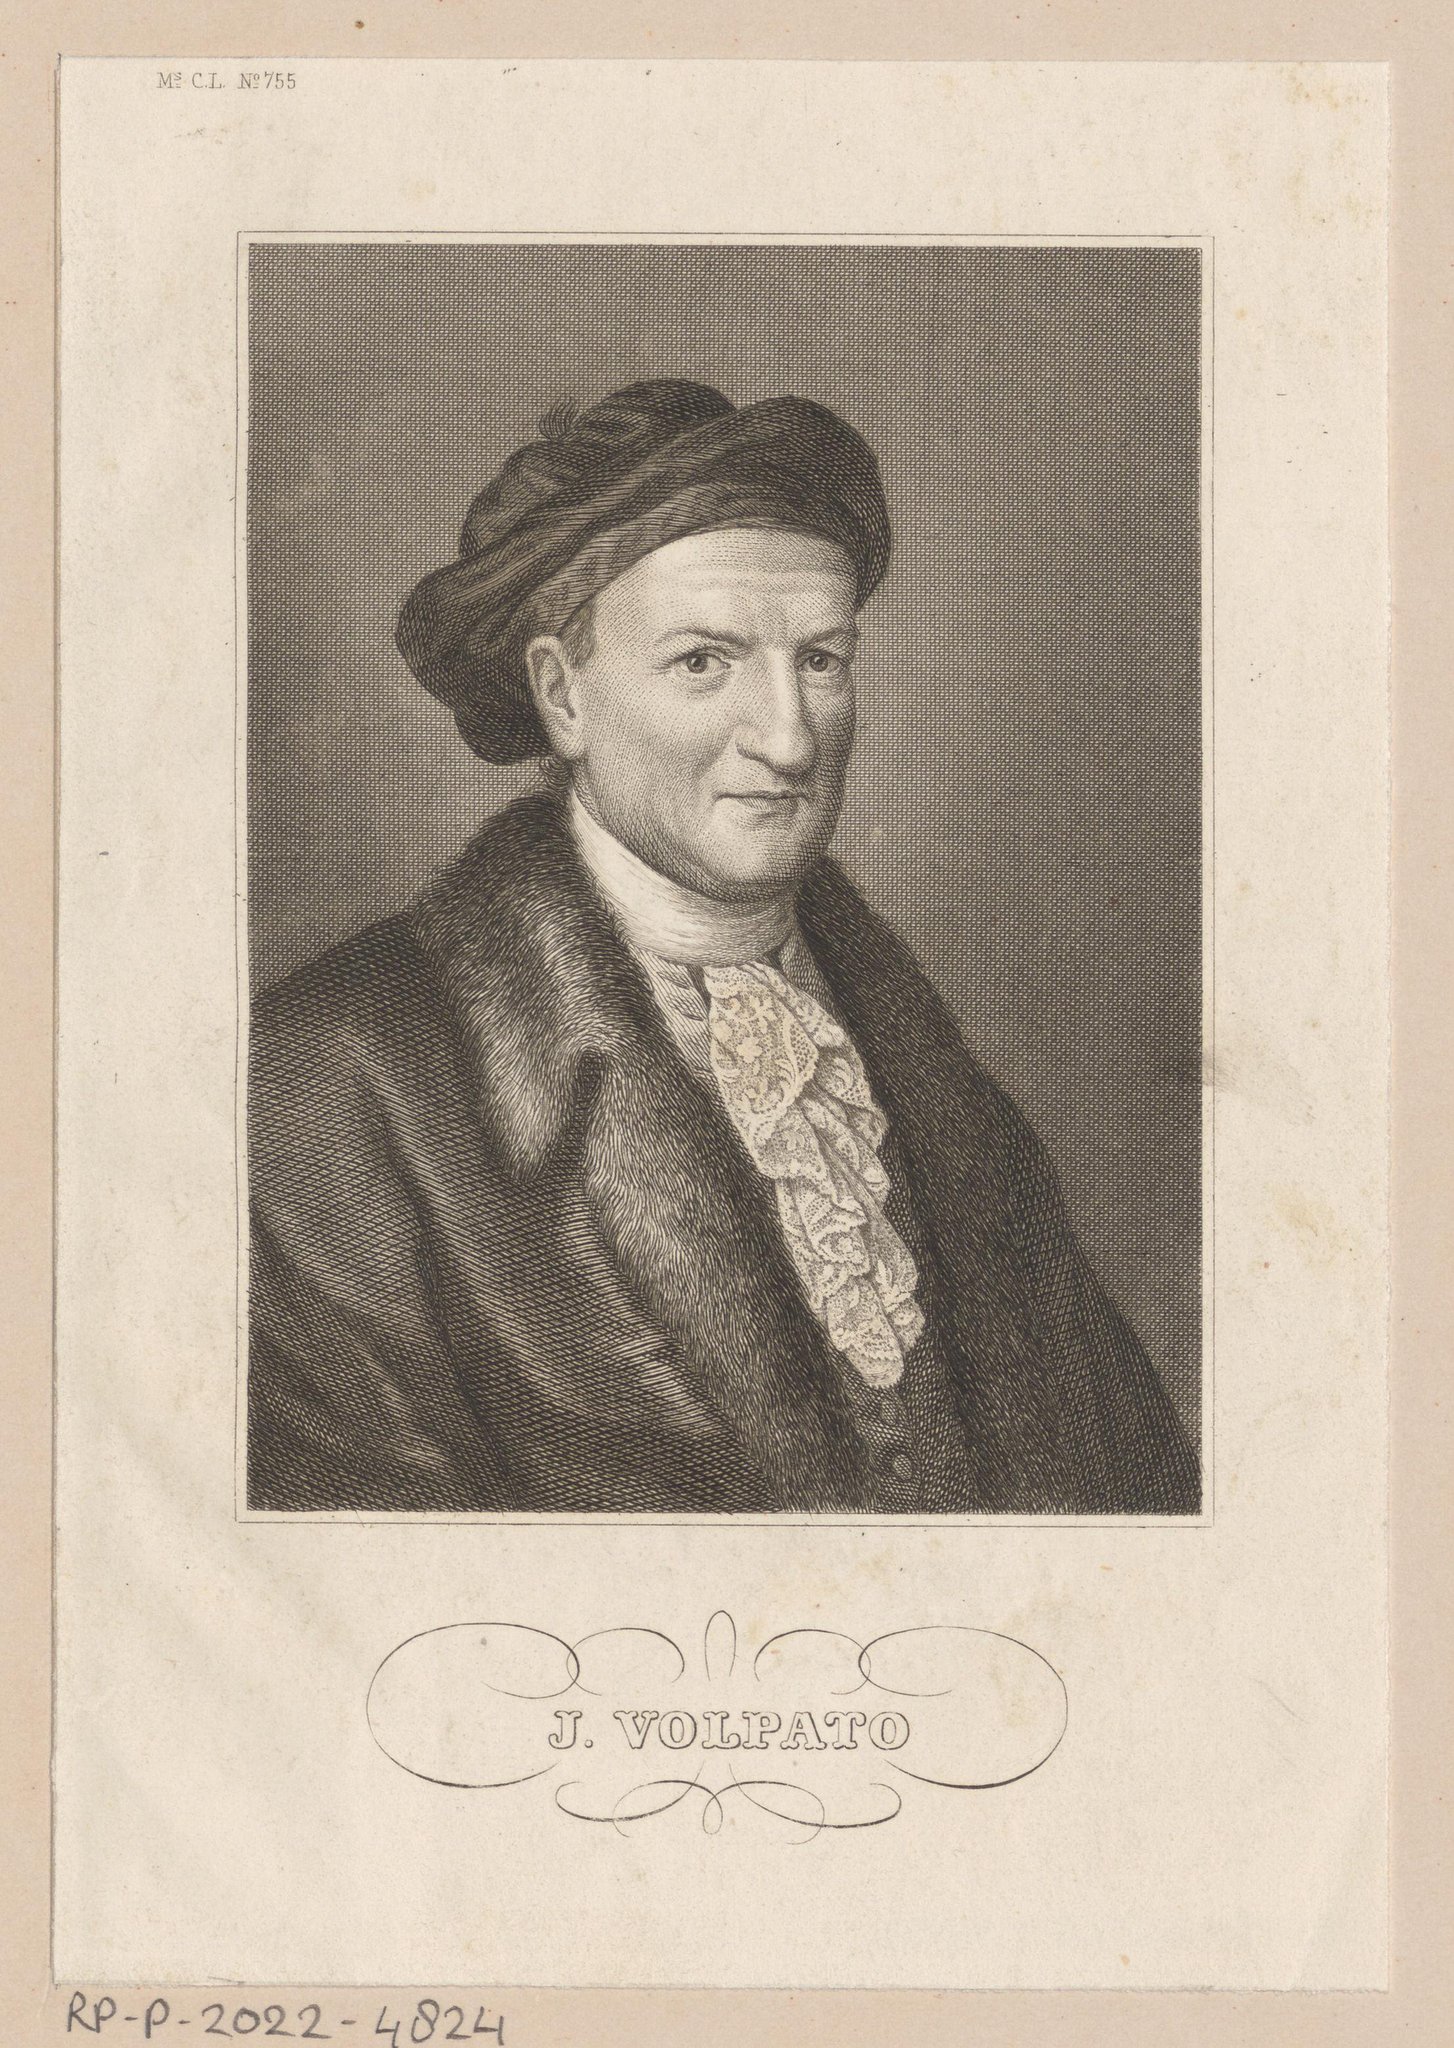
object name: print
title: J. Volpato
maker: Anonymous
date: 1839-1855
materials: paper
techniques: engraving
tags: rome, historical persons, art dealer, portrait, self-portrait of graphic artist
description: Prent uit: Meyer, Joseph. Das große Conversations-Lexikon für die gebildeten Stände. 52 dln. Hildburghausen: Bibliographisches Institut, [1839-1855].